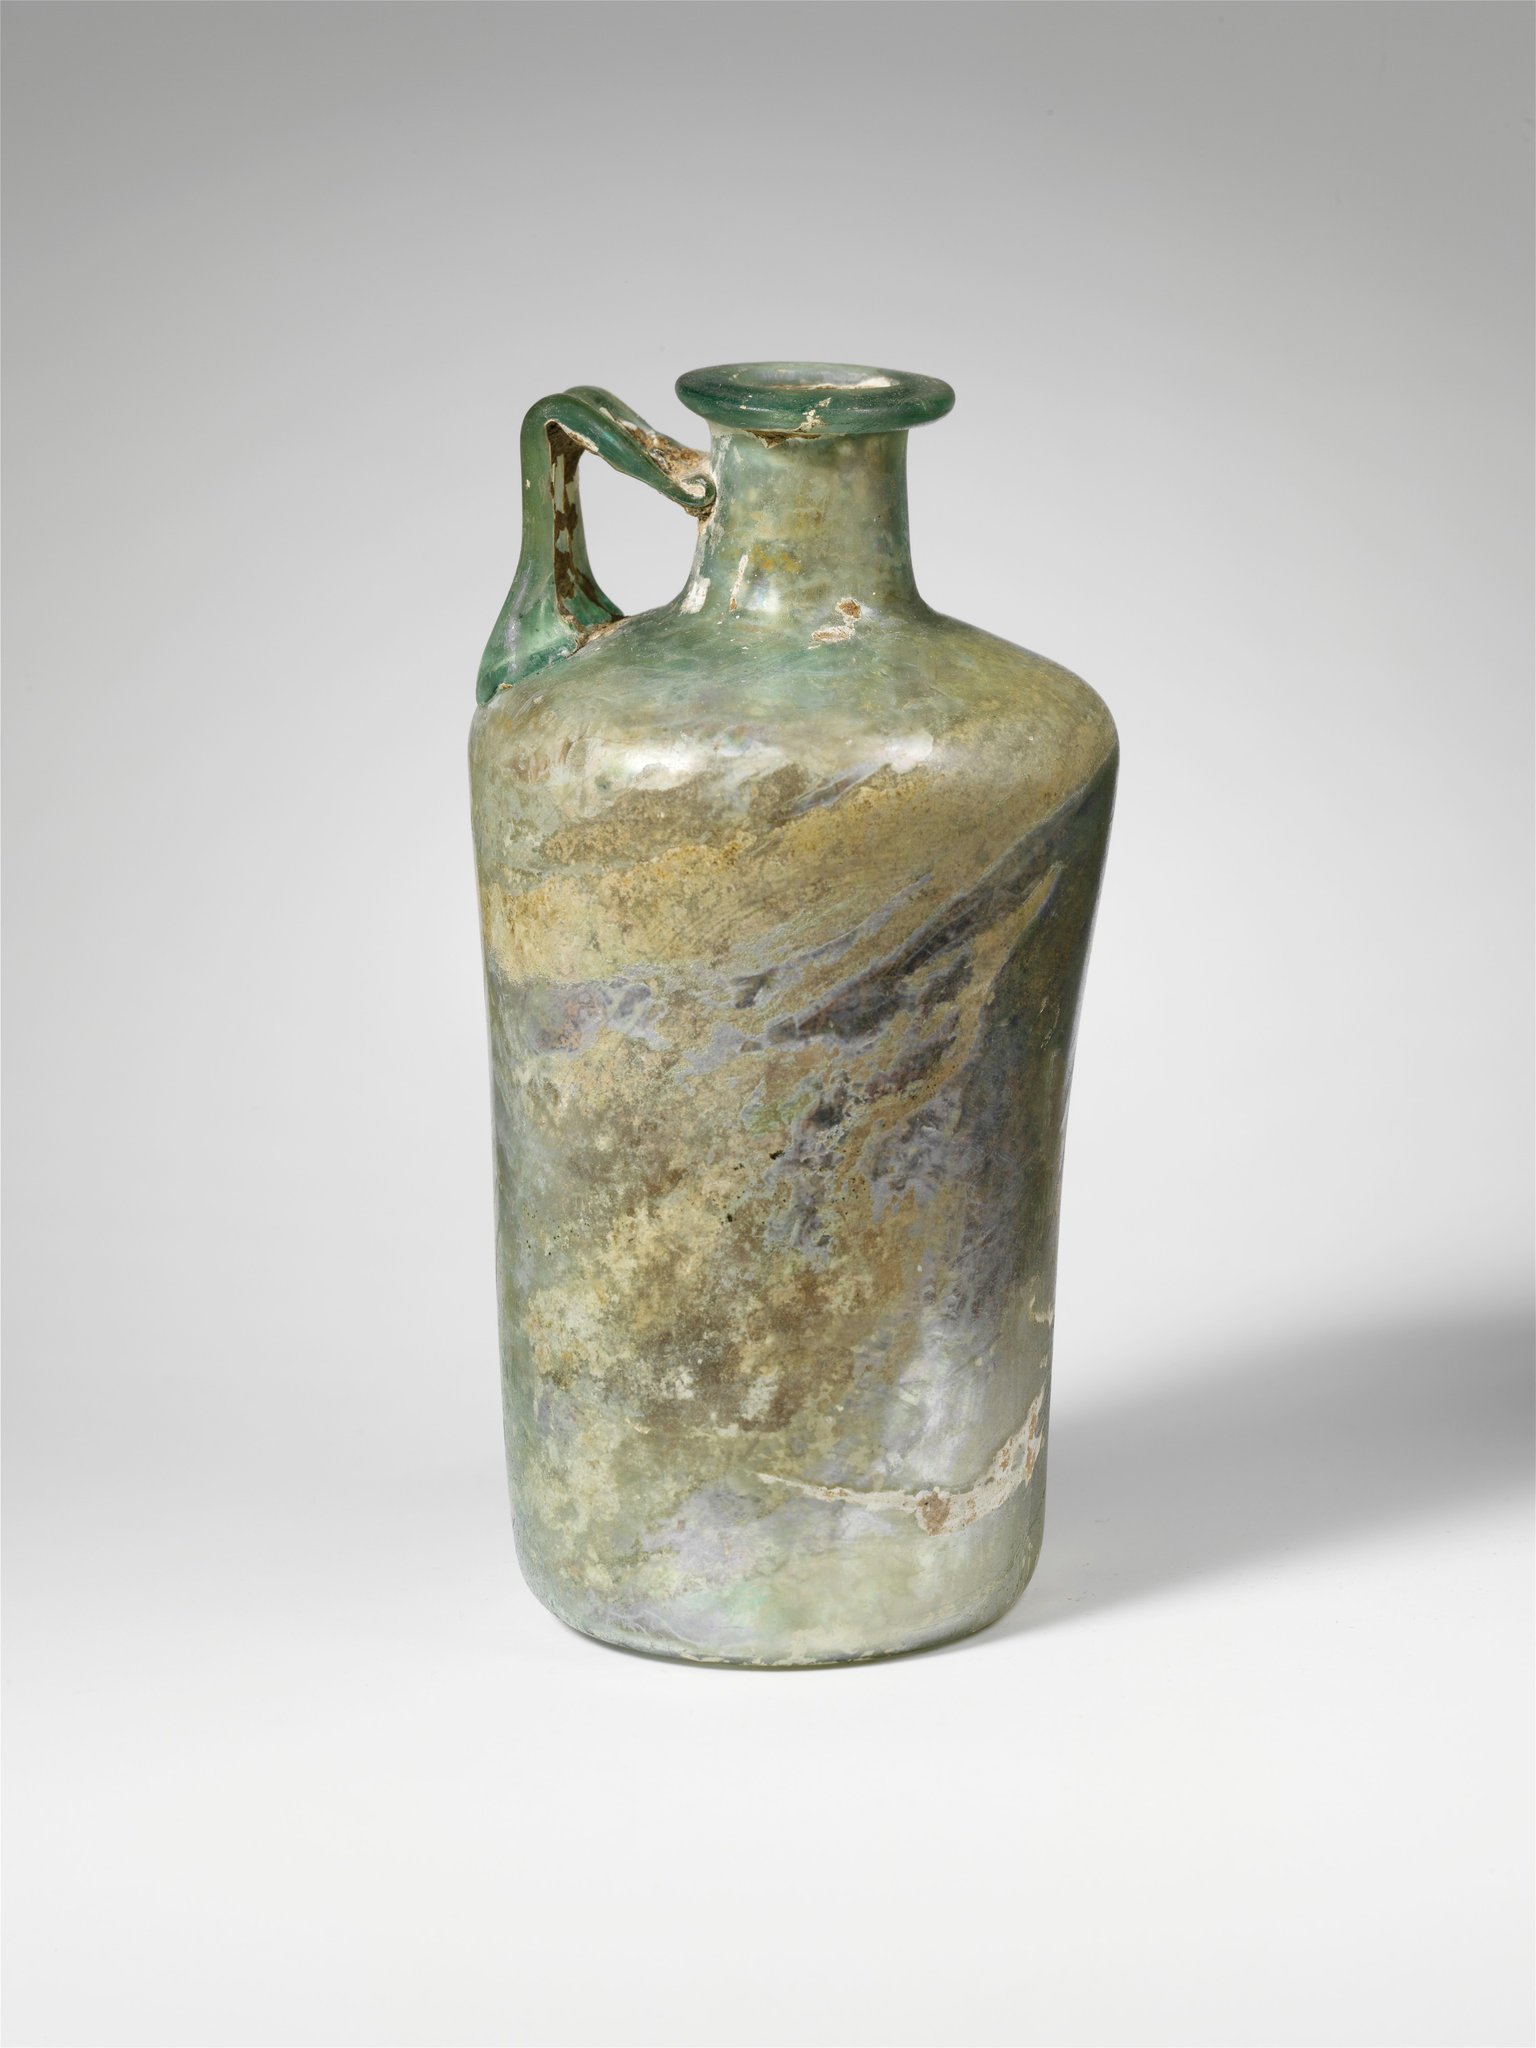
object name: jug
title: Glass cylindrical jug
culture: roman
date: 1-300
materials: glass